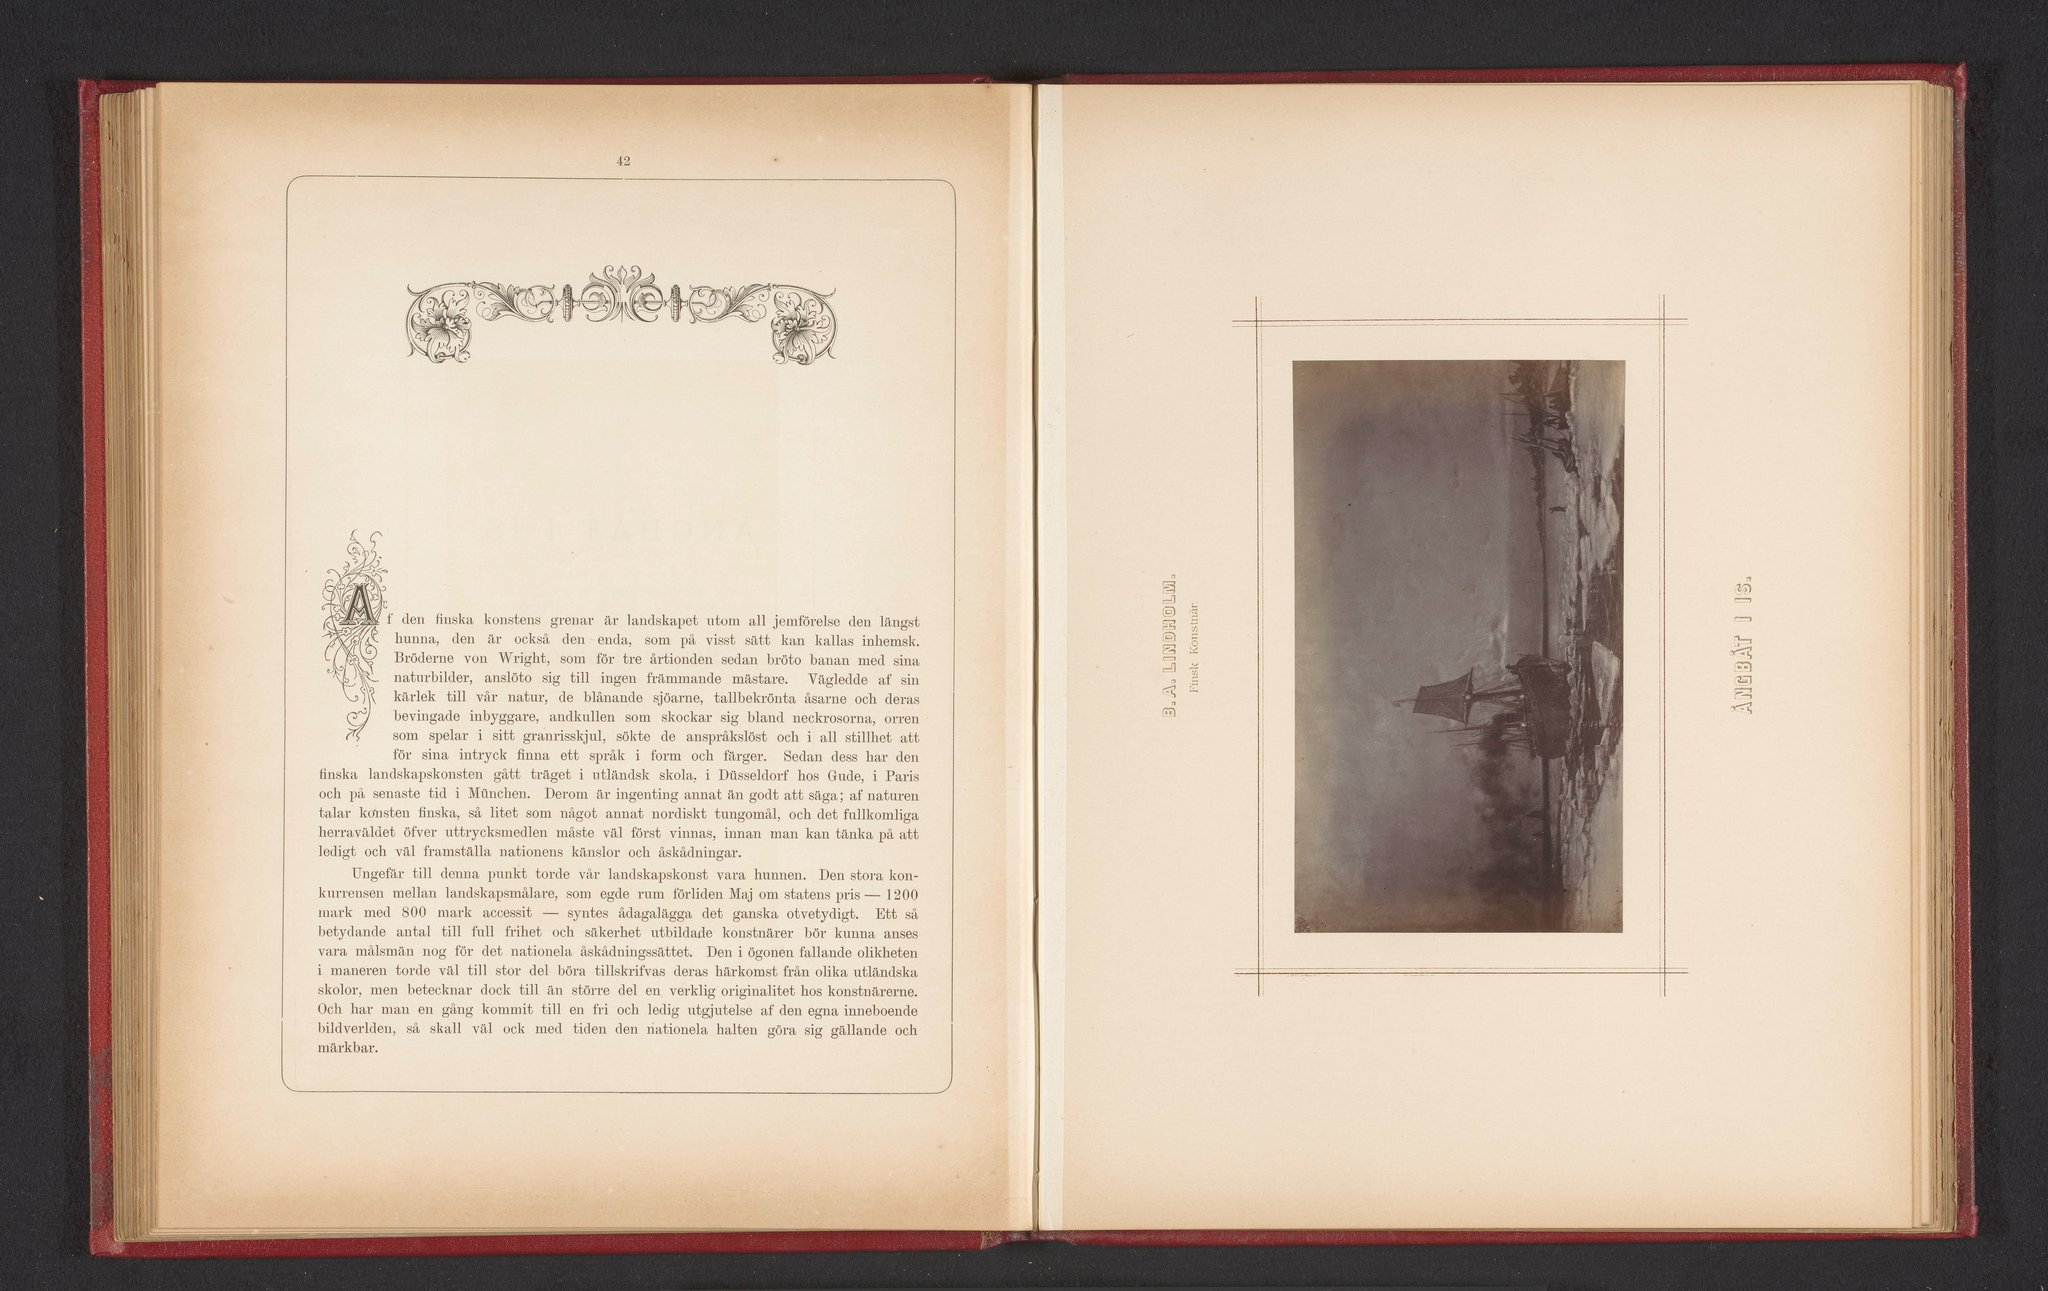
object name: page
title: Angbåt I Is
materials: photographic support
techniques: albumen print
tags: sailing-ship, sailing-boat, sea (seascape), drift ice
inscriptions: inscription: ‘Finsk Konstnär’